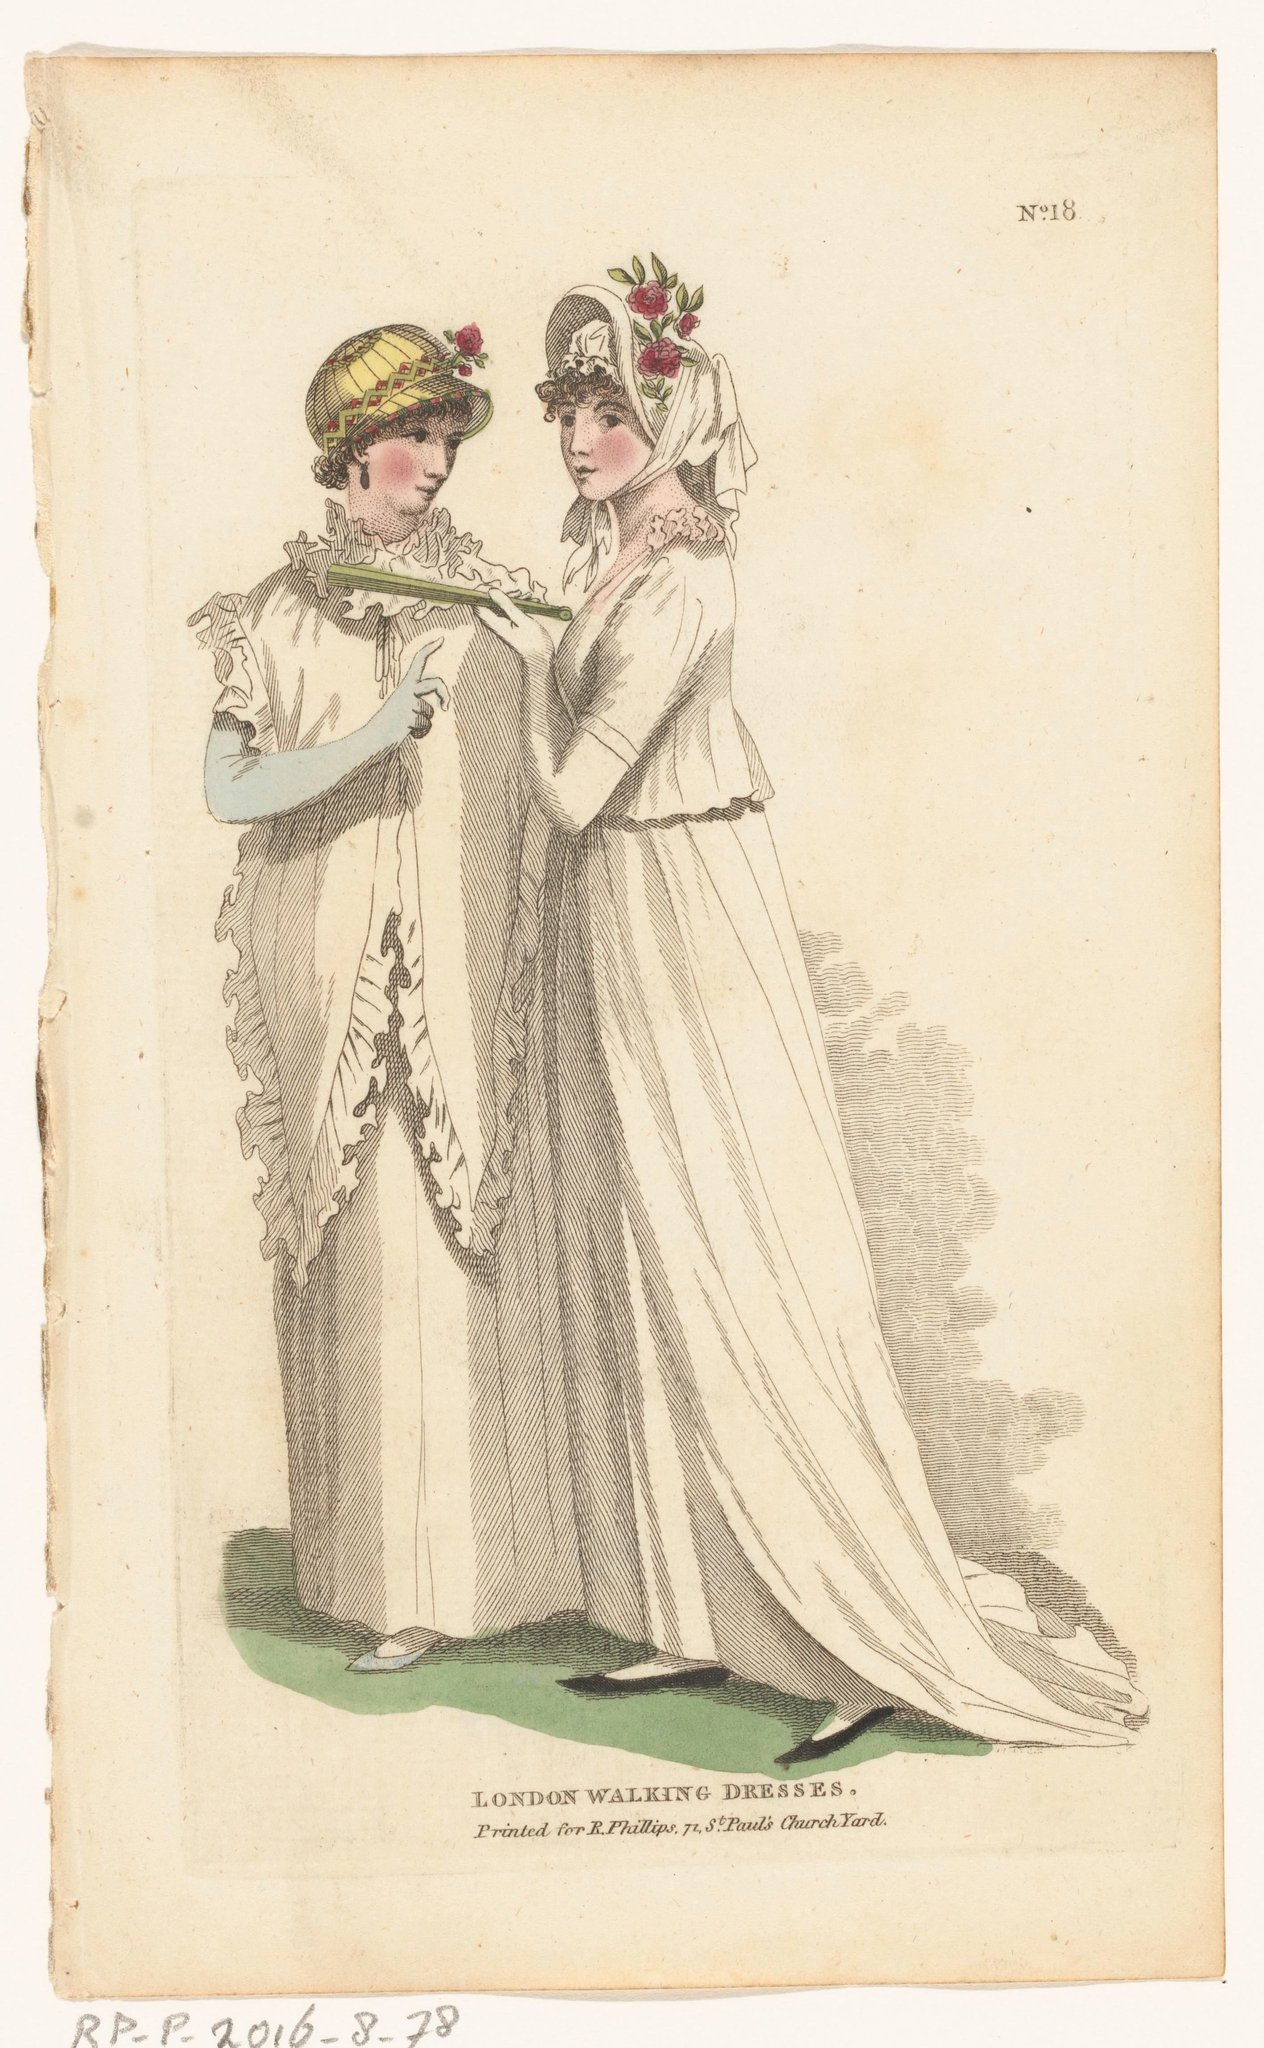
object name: fashion print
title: Magazine of Female Fashions of London and Paris: London walking dresses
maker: richard phillips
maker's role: bookseller, publisher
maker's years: 1767-1840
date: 1798-1806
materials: paper, ink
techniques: engraving, hand coloring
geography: london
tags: fashion plates